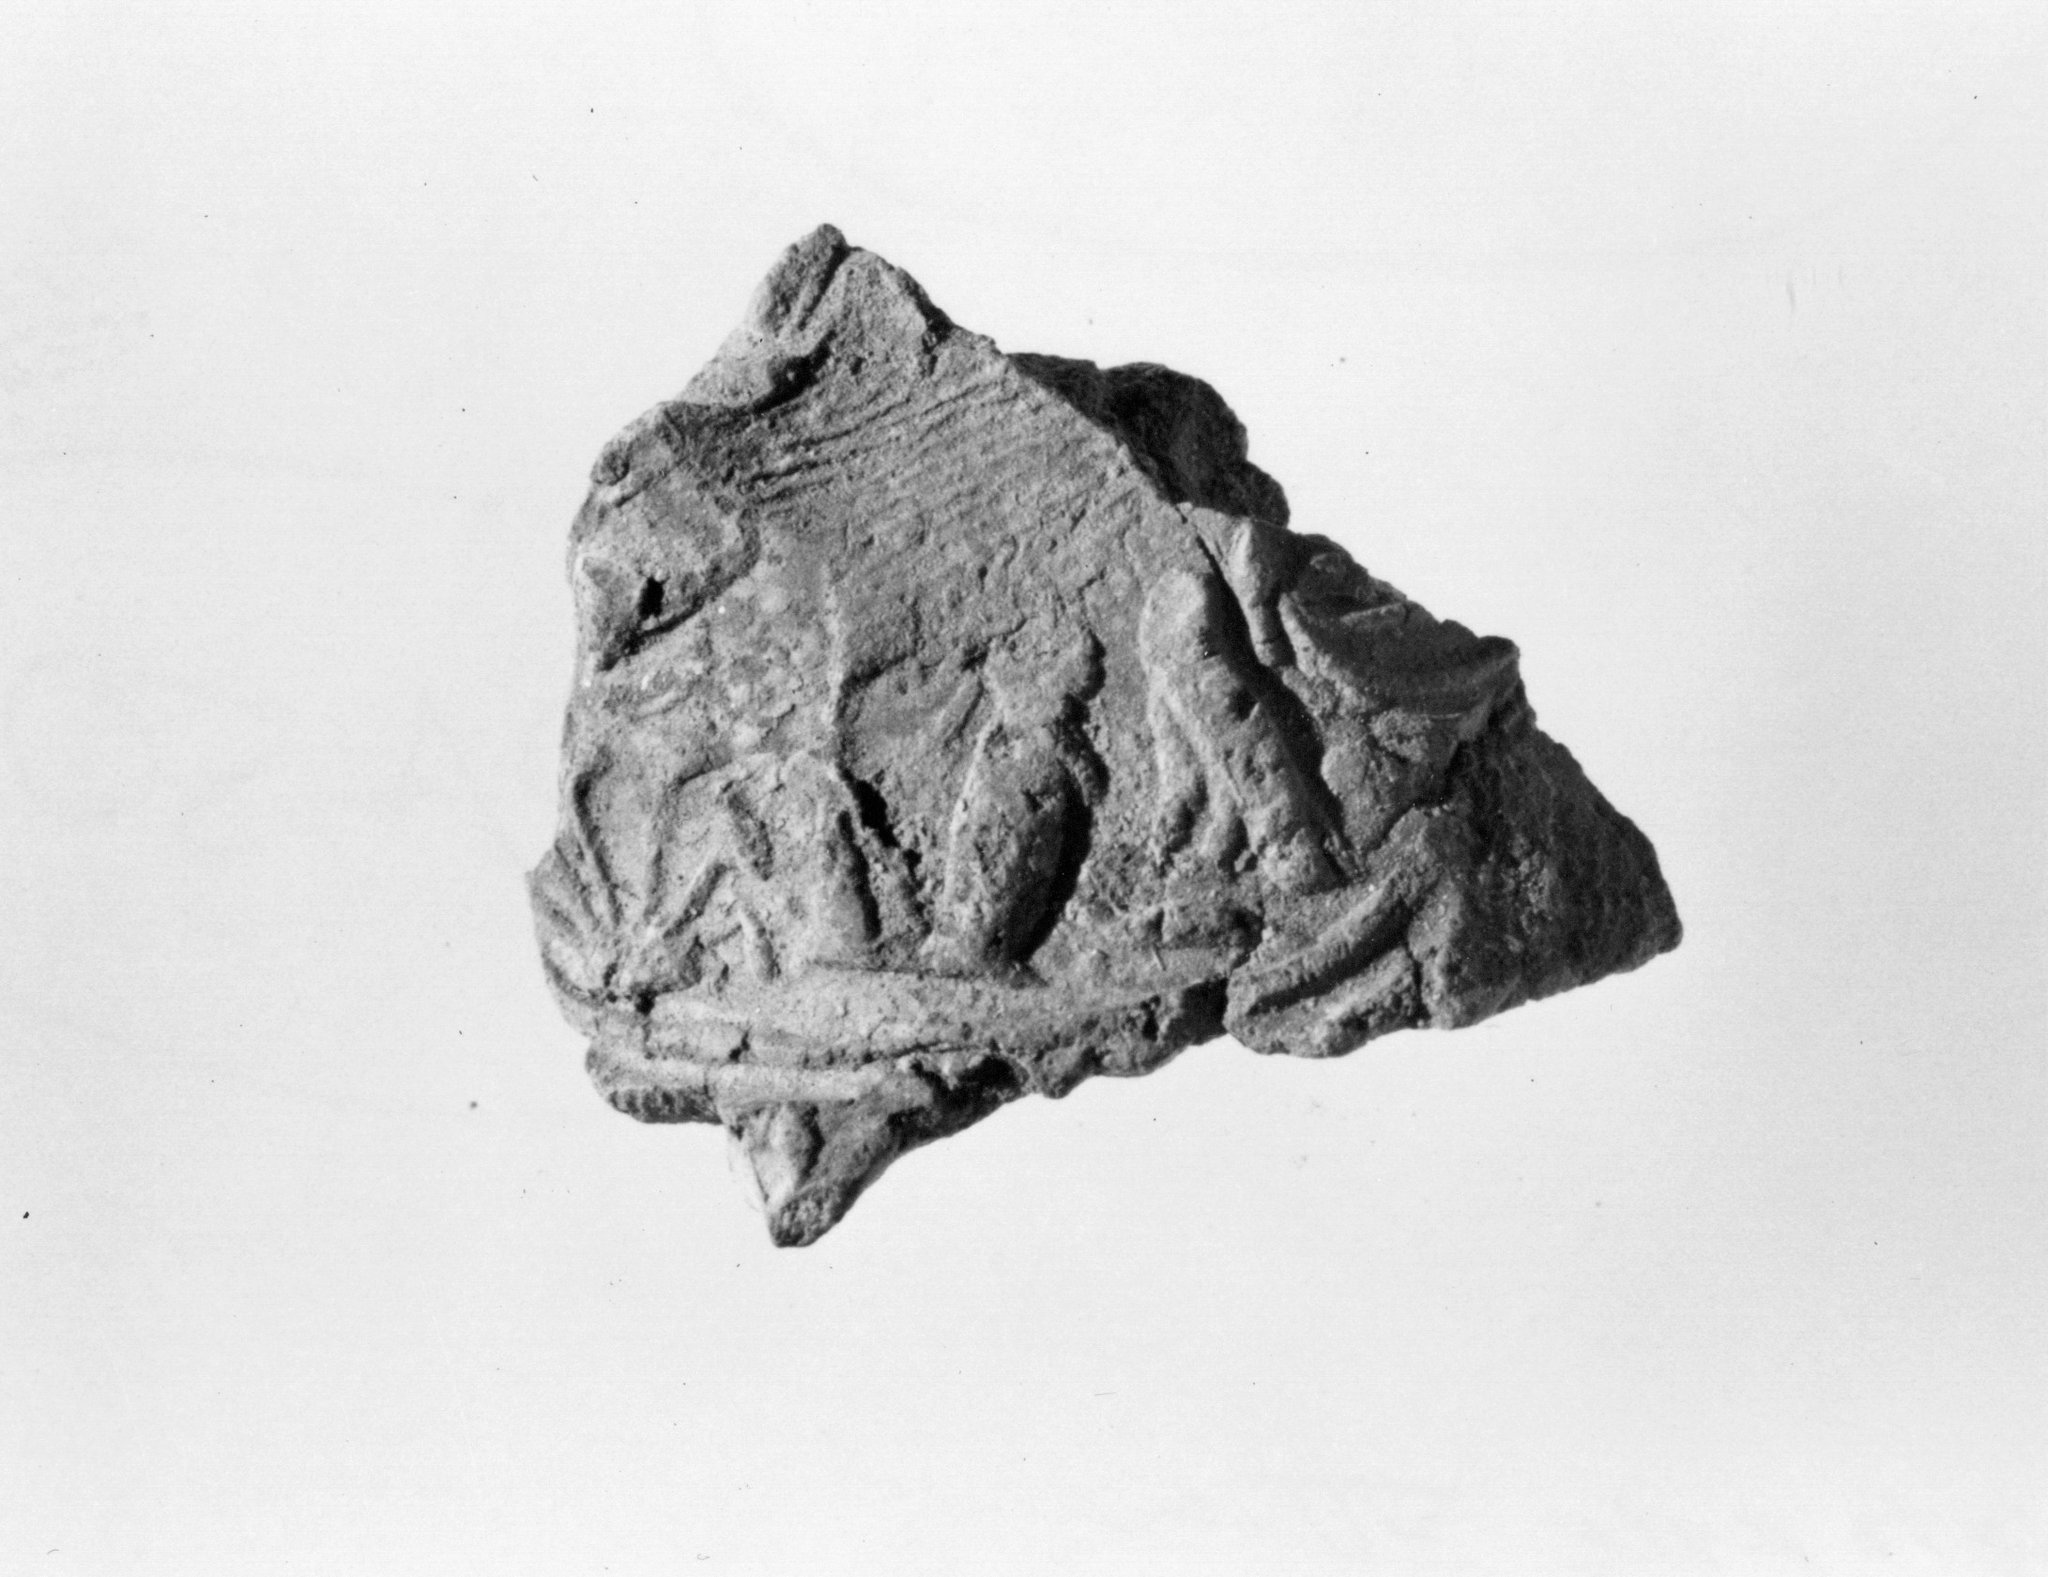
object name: sealing, nebmaatre, amenhotep iii, lower egypt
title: Document Sealing With the Throne Name of Amenhotep III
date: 1390-1352 BCE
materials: mud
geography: egypt